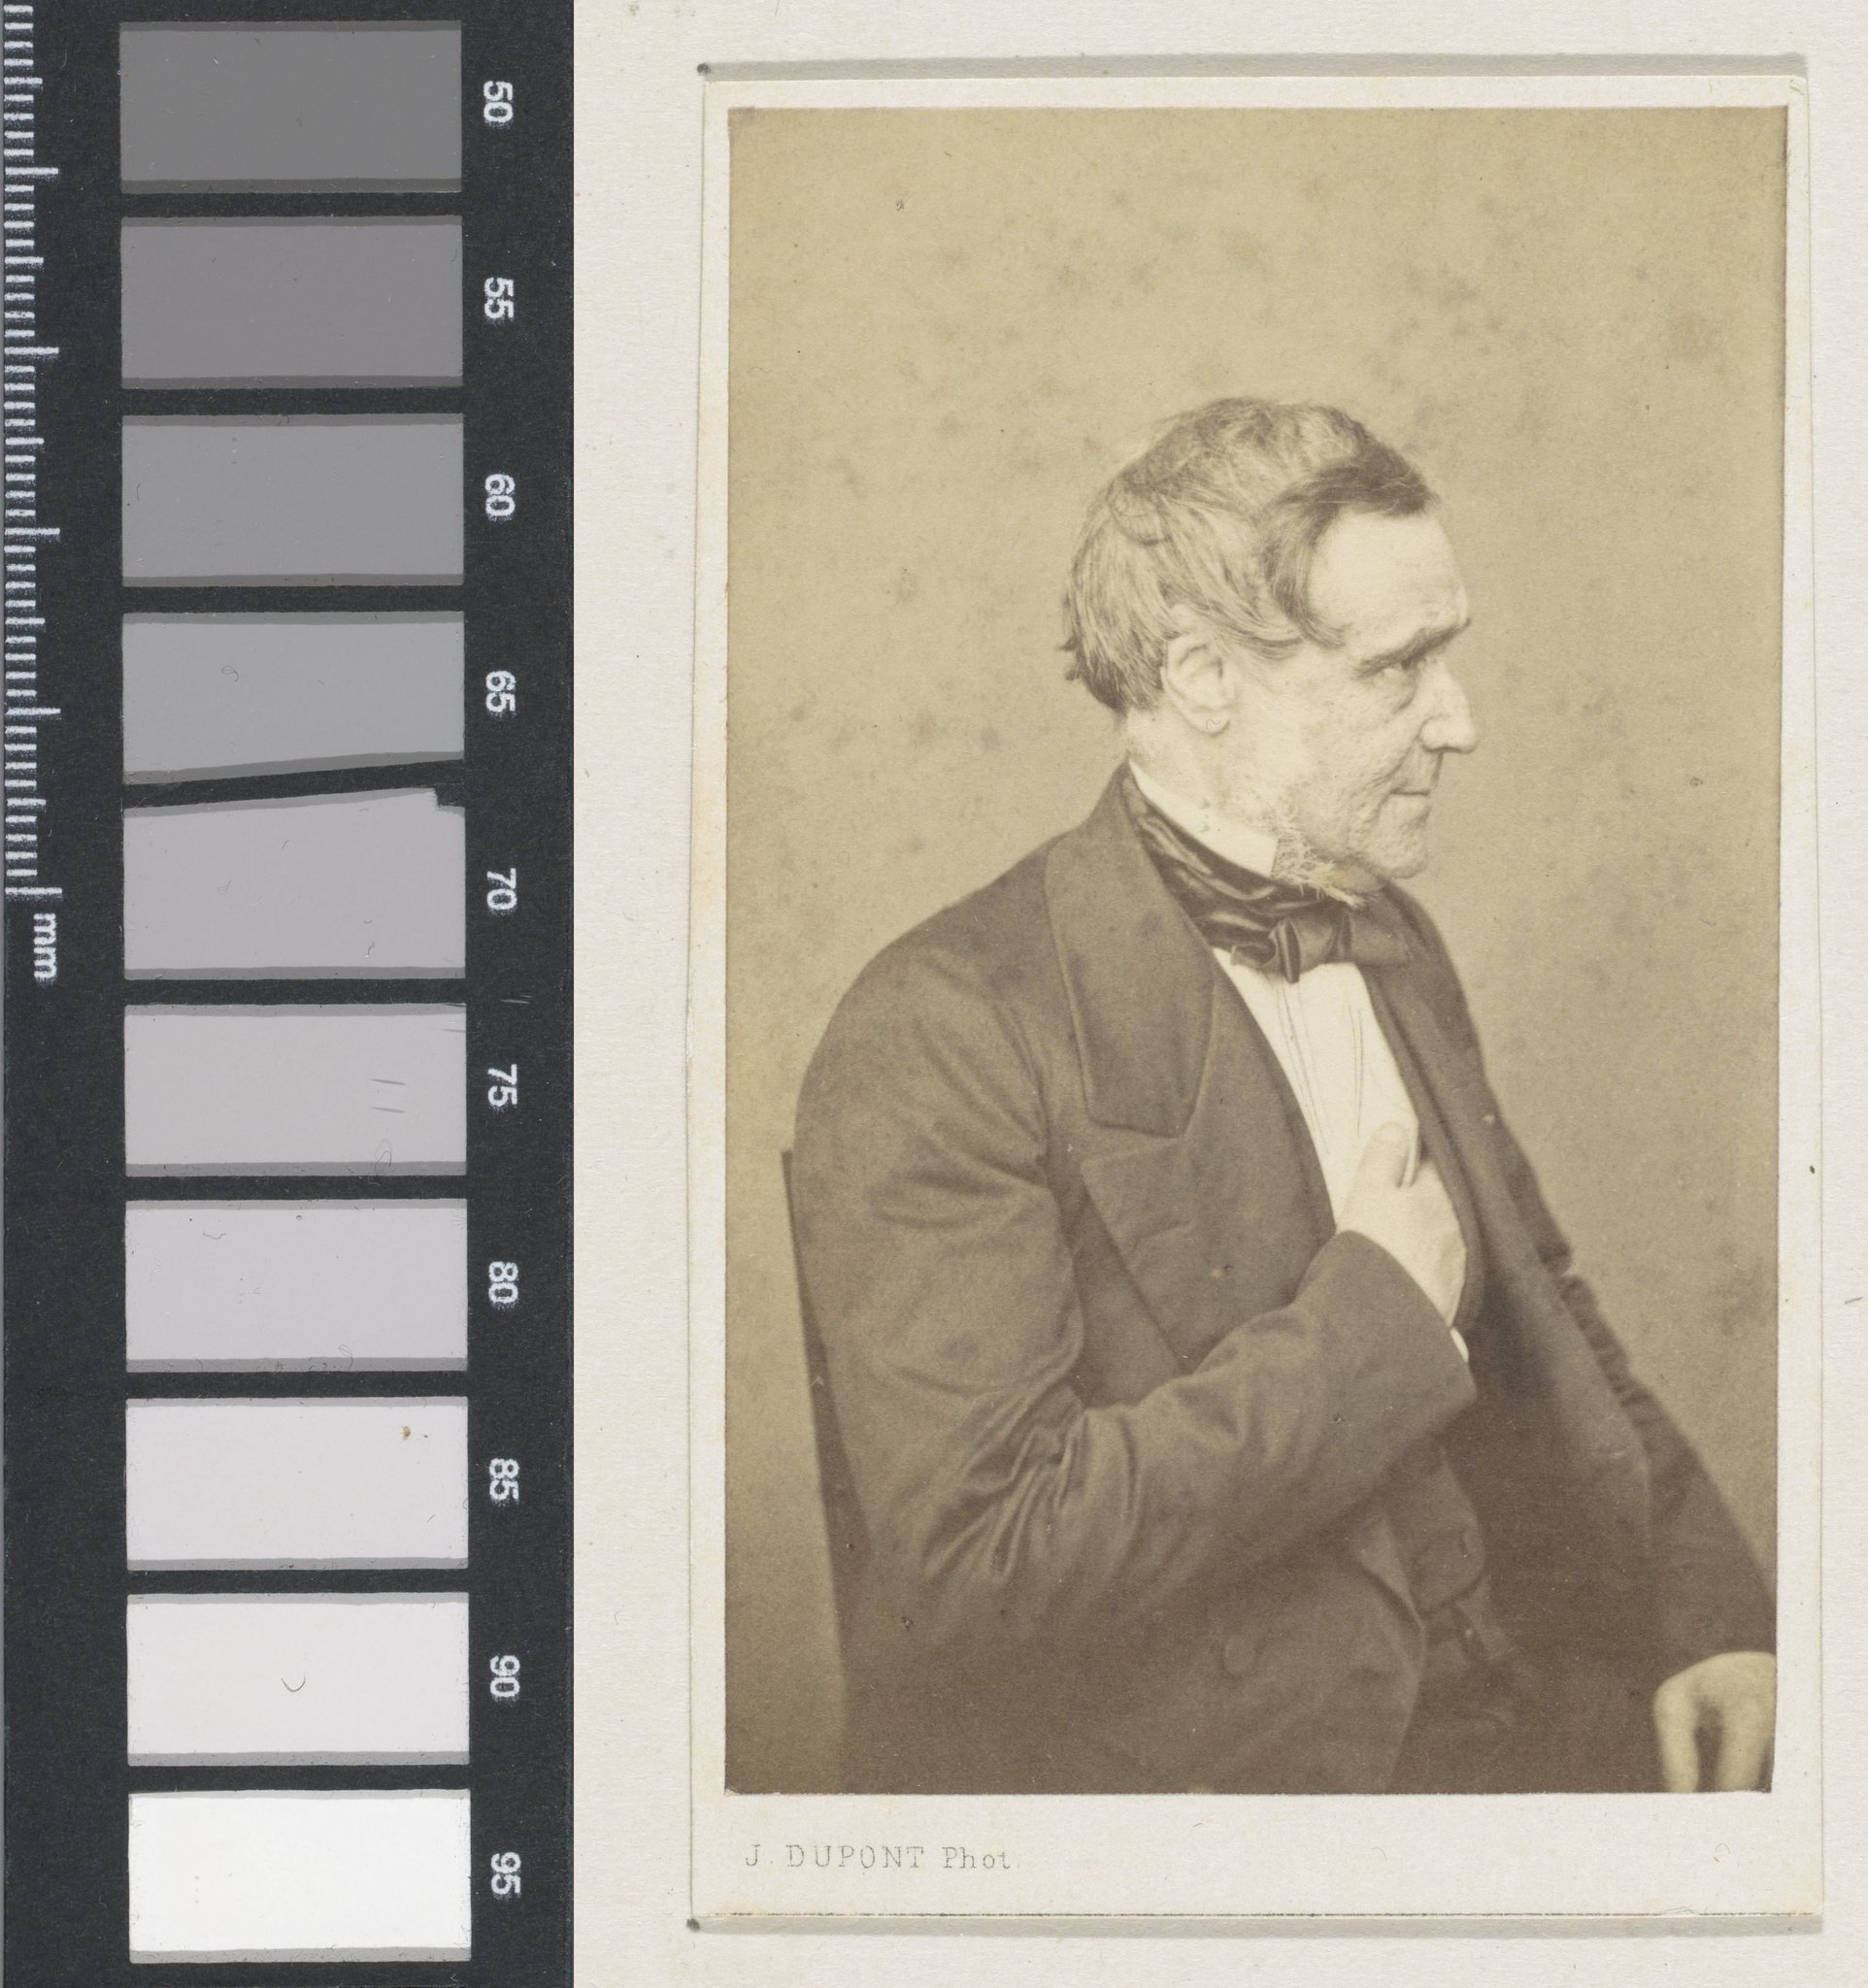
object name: photograph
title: L'École d'Anvers. Portraits biographies cartes de visite. Collection Dupont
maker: joseph dupont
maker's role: fotograaf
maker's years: 1818-1901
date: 1861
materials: cardboard, paper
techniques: albumen print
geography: antwerp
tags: brussels, print maker, draughtsman, antoon van ijsendijck, historical persons, portrait, self-portrait of painter, portrait, self-portrait of artist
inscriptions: inscription: ‘ETABLISSEMENT PHOTOGRAPHIQUE/ de/ J. DUPONT/ Place de Meir 32/ ANVERS/ Maison fondée en 18533’, inscription: ‘v. Ysendyck’